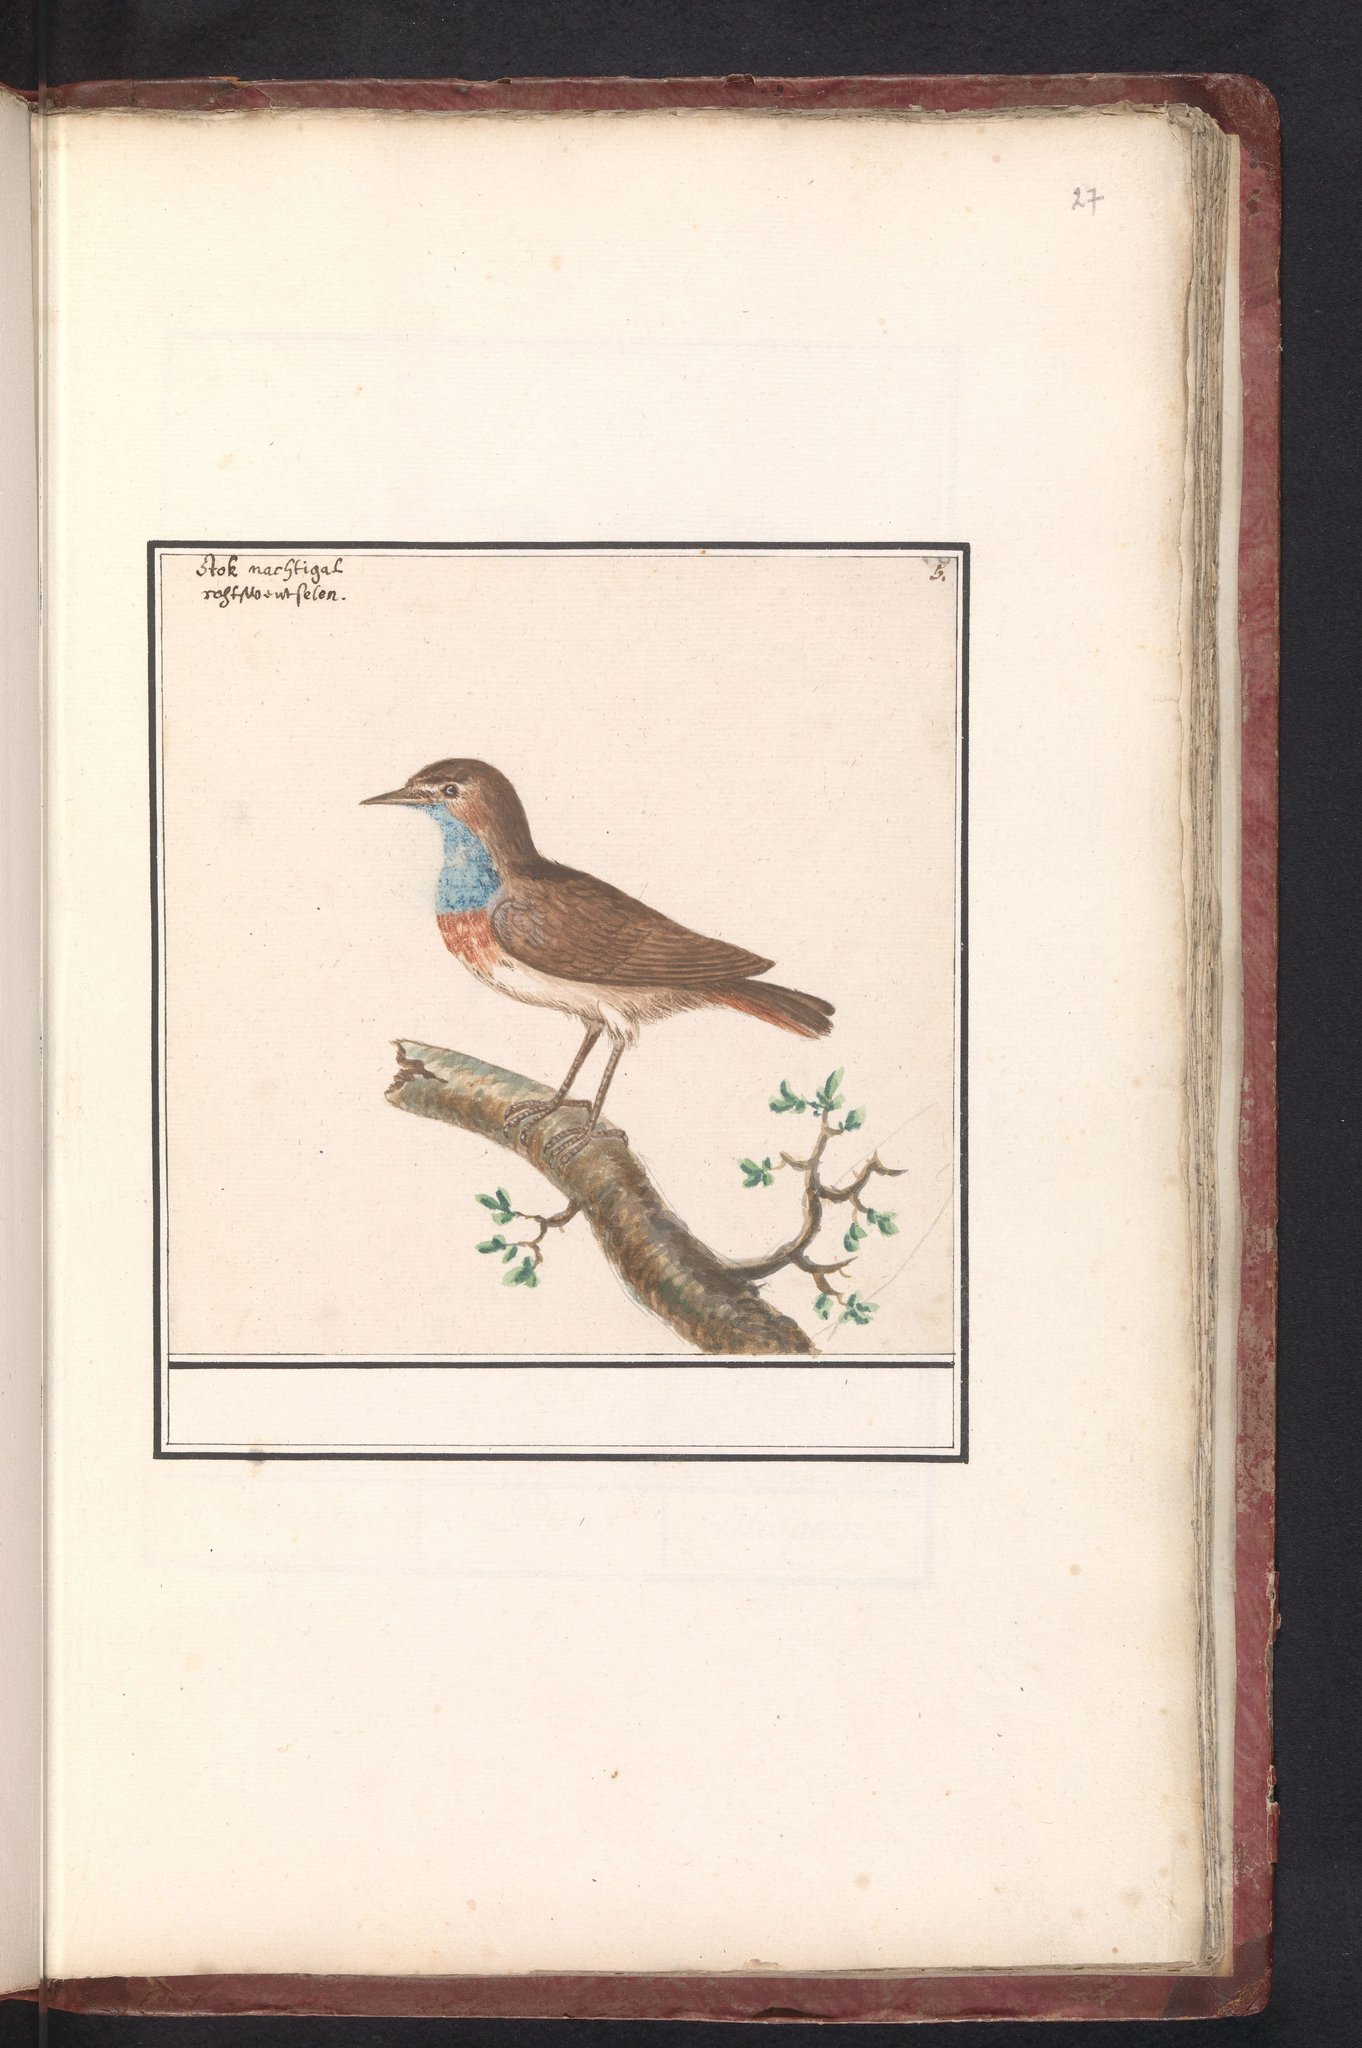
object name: drawing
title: Blauwborst (Luscinia svecica)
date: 1596-1610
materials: paint, ink, paper, pencil, watercolor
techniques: brush, pen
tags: song-birds: bluethroat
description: Blauwborst. Genummerd rechtsboven: 5. Linksboven de naam in Duits. Onderdeel van het tweede album met tekeningen van vogels. Vierde van twaalf albums met tekeningen van dieren, vogels en planten bekend rond 1600, gemaakt in opdracht van keizer Rudolf II. Met toelichting in Nederlands, Latijn en Frans.